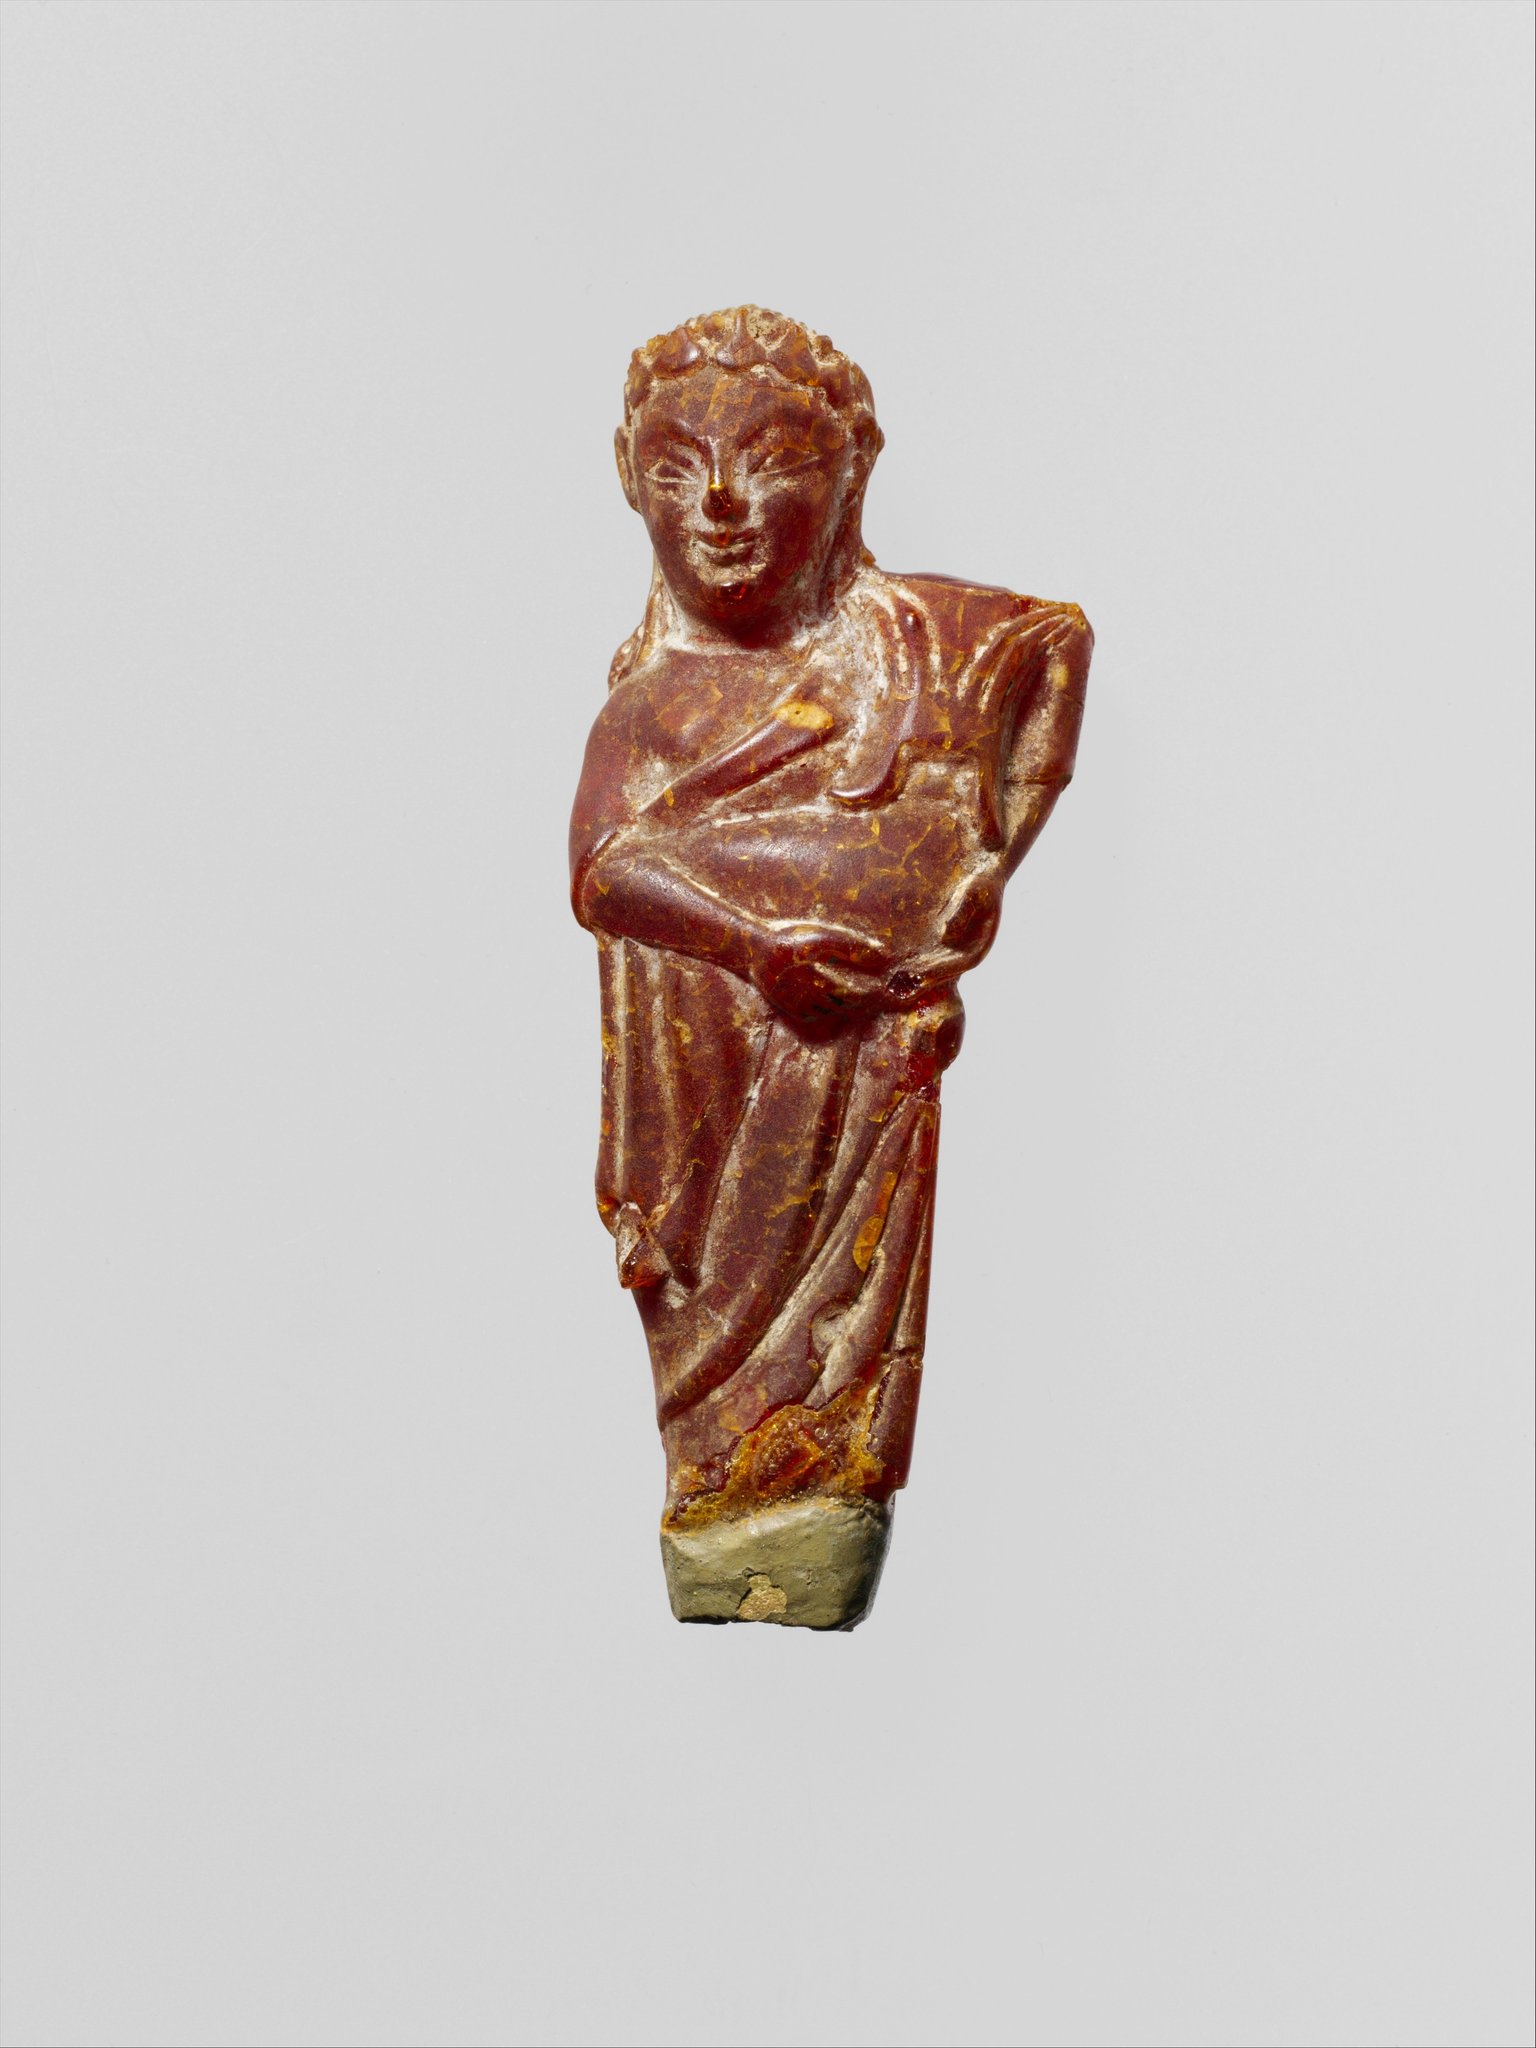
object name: statuette, woman and child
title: Pendant: woman carrying a child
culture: etruscan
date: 500-401 BCE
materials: amber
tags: infants,women